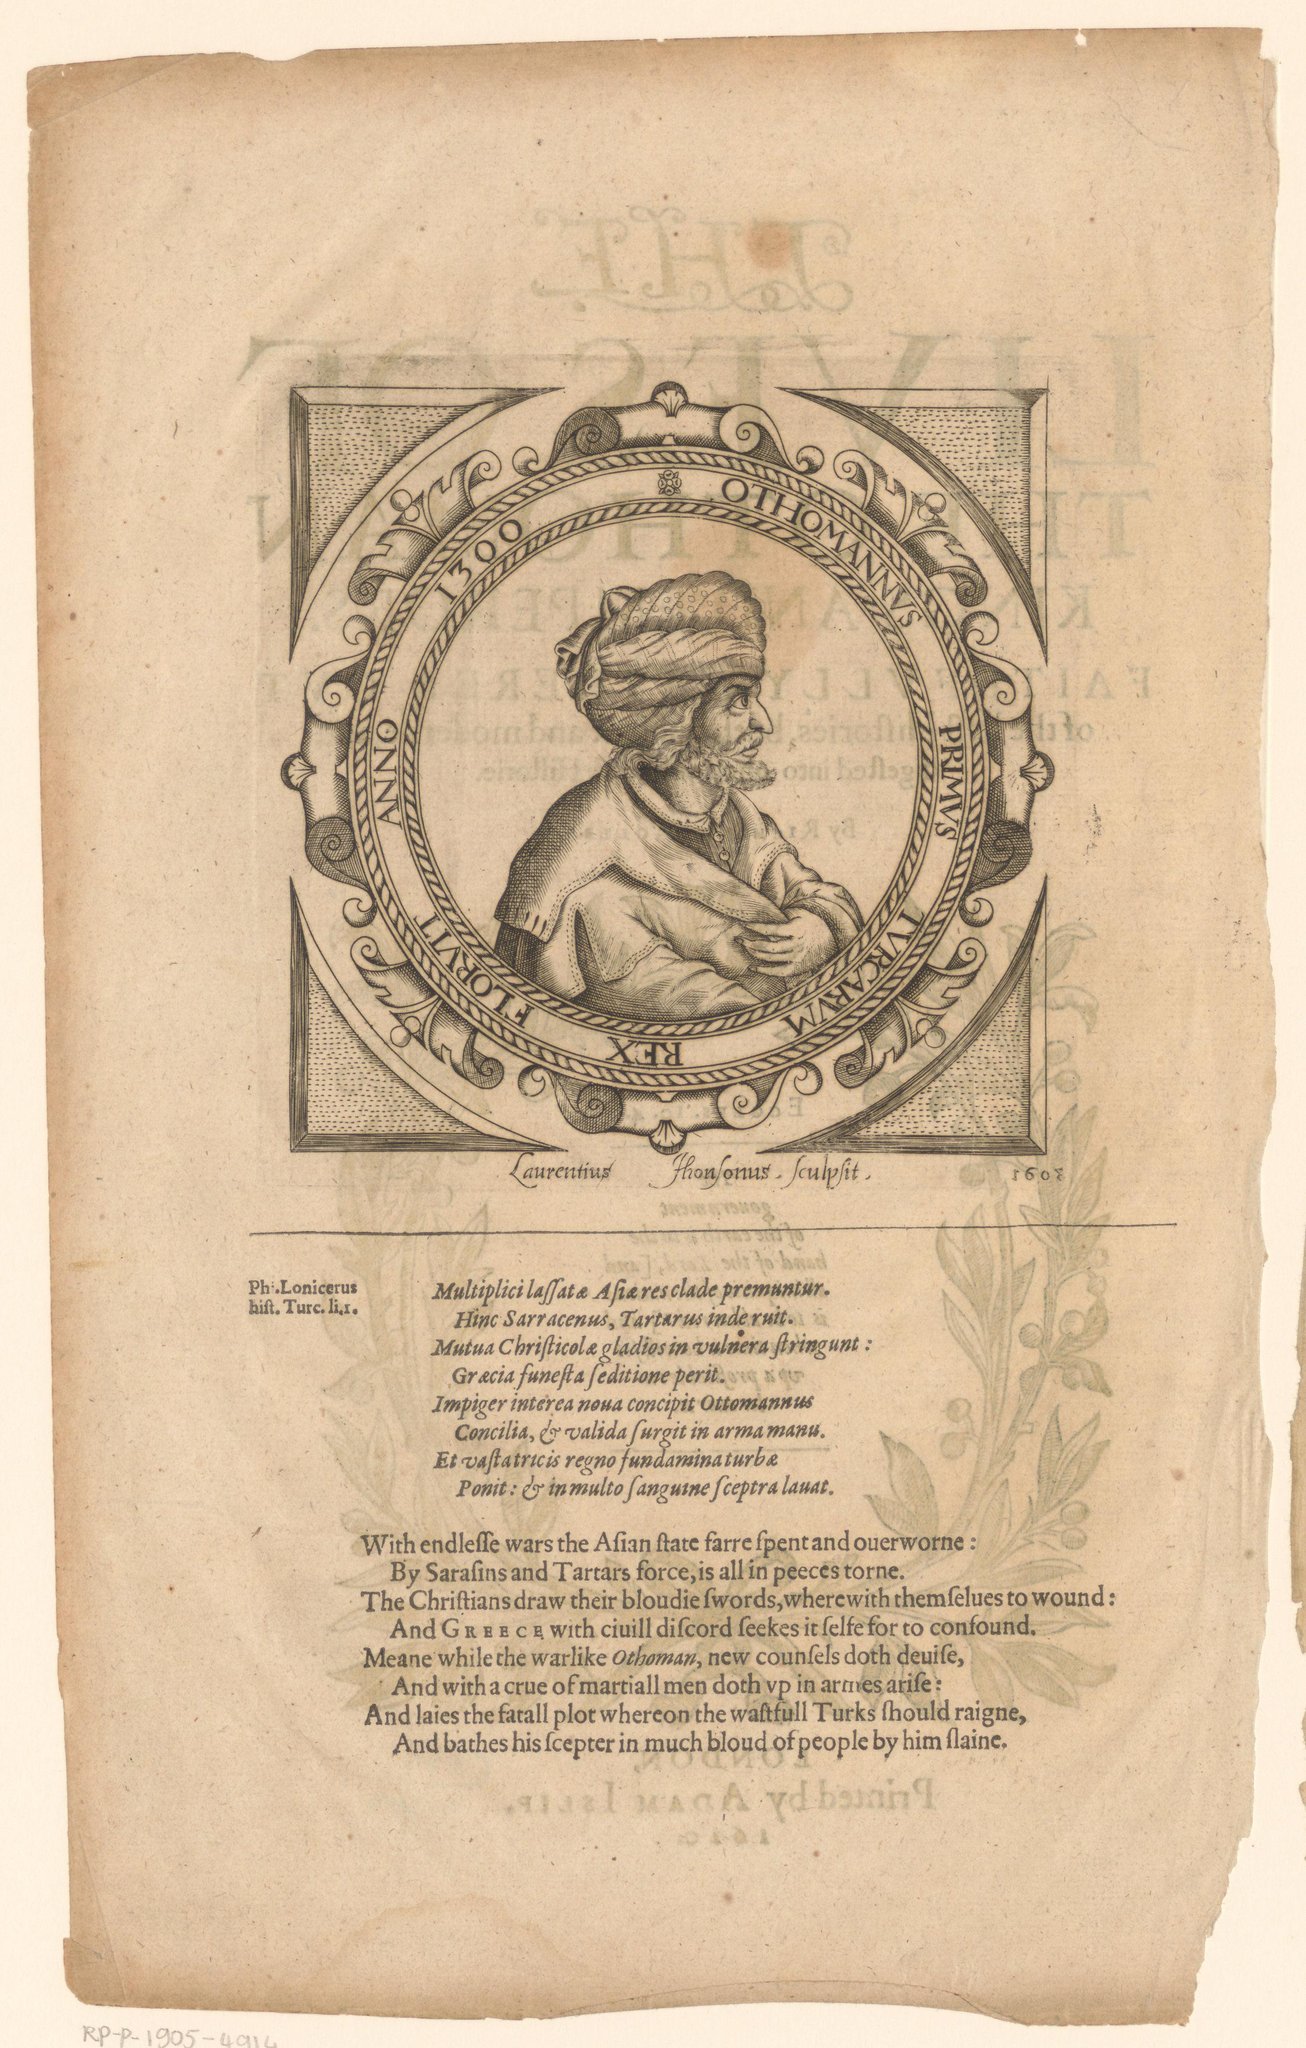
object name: book illustration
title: Othomannus Primus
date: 1603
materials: paper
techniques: engraving, letterpress printing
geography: london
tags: historical persons, ruler, sovereign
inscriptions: collector's mark: Lugt 2228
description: Prent gebruikt in: Knolles, Richard. The lives of the Othoman Kings and Emperors (...). Londen: Adam Islip, 1603. Prent ook gebruikt in: Knolles, Richard. The Generall Historie of the Turkes from the First Beginning of that Nation to the Rising of the Othoman Familie. Londen: Adam Islip, 1603.